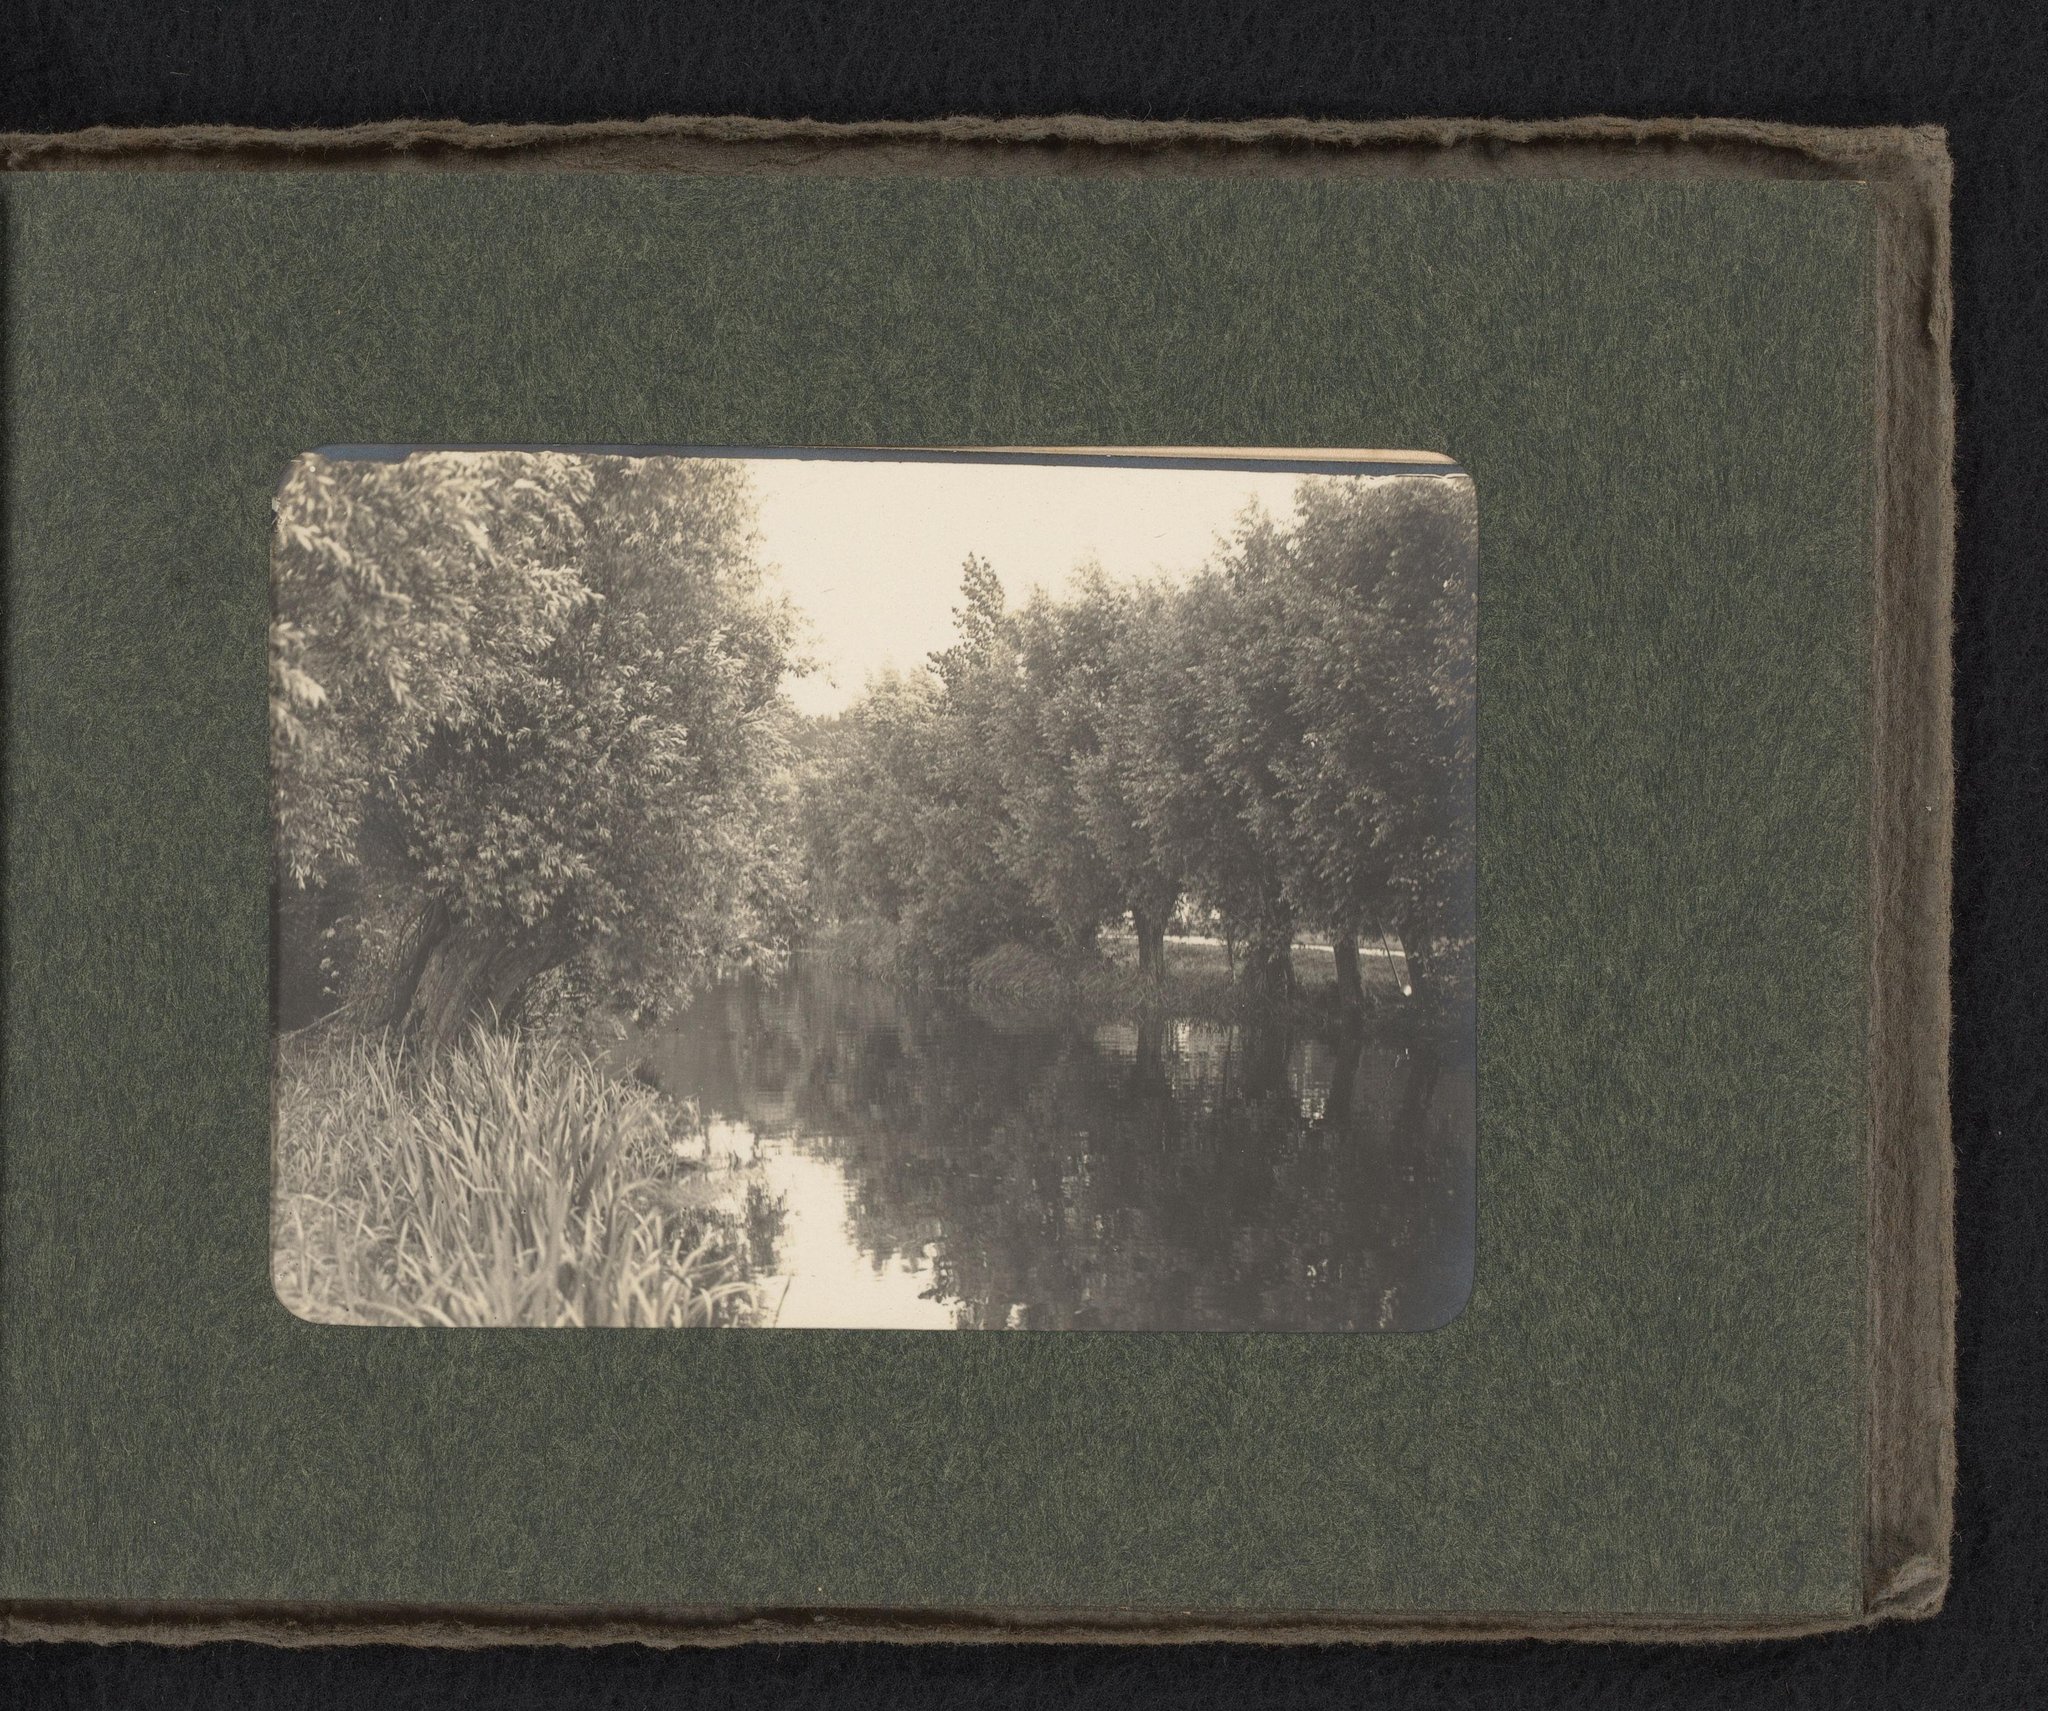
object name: album leaf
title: Gezicht op een beek nabij hotel Bosch van Bredius te Laren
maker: hendrik herman van den berg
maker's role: amateurfotograaf, jurist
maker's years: 1875-1944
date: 1912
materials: paper, cardboard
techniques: gelatin silver print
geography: laren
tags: brook